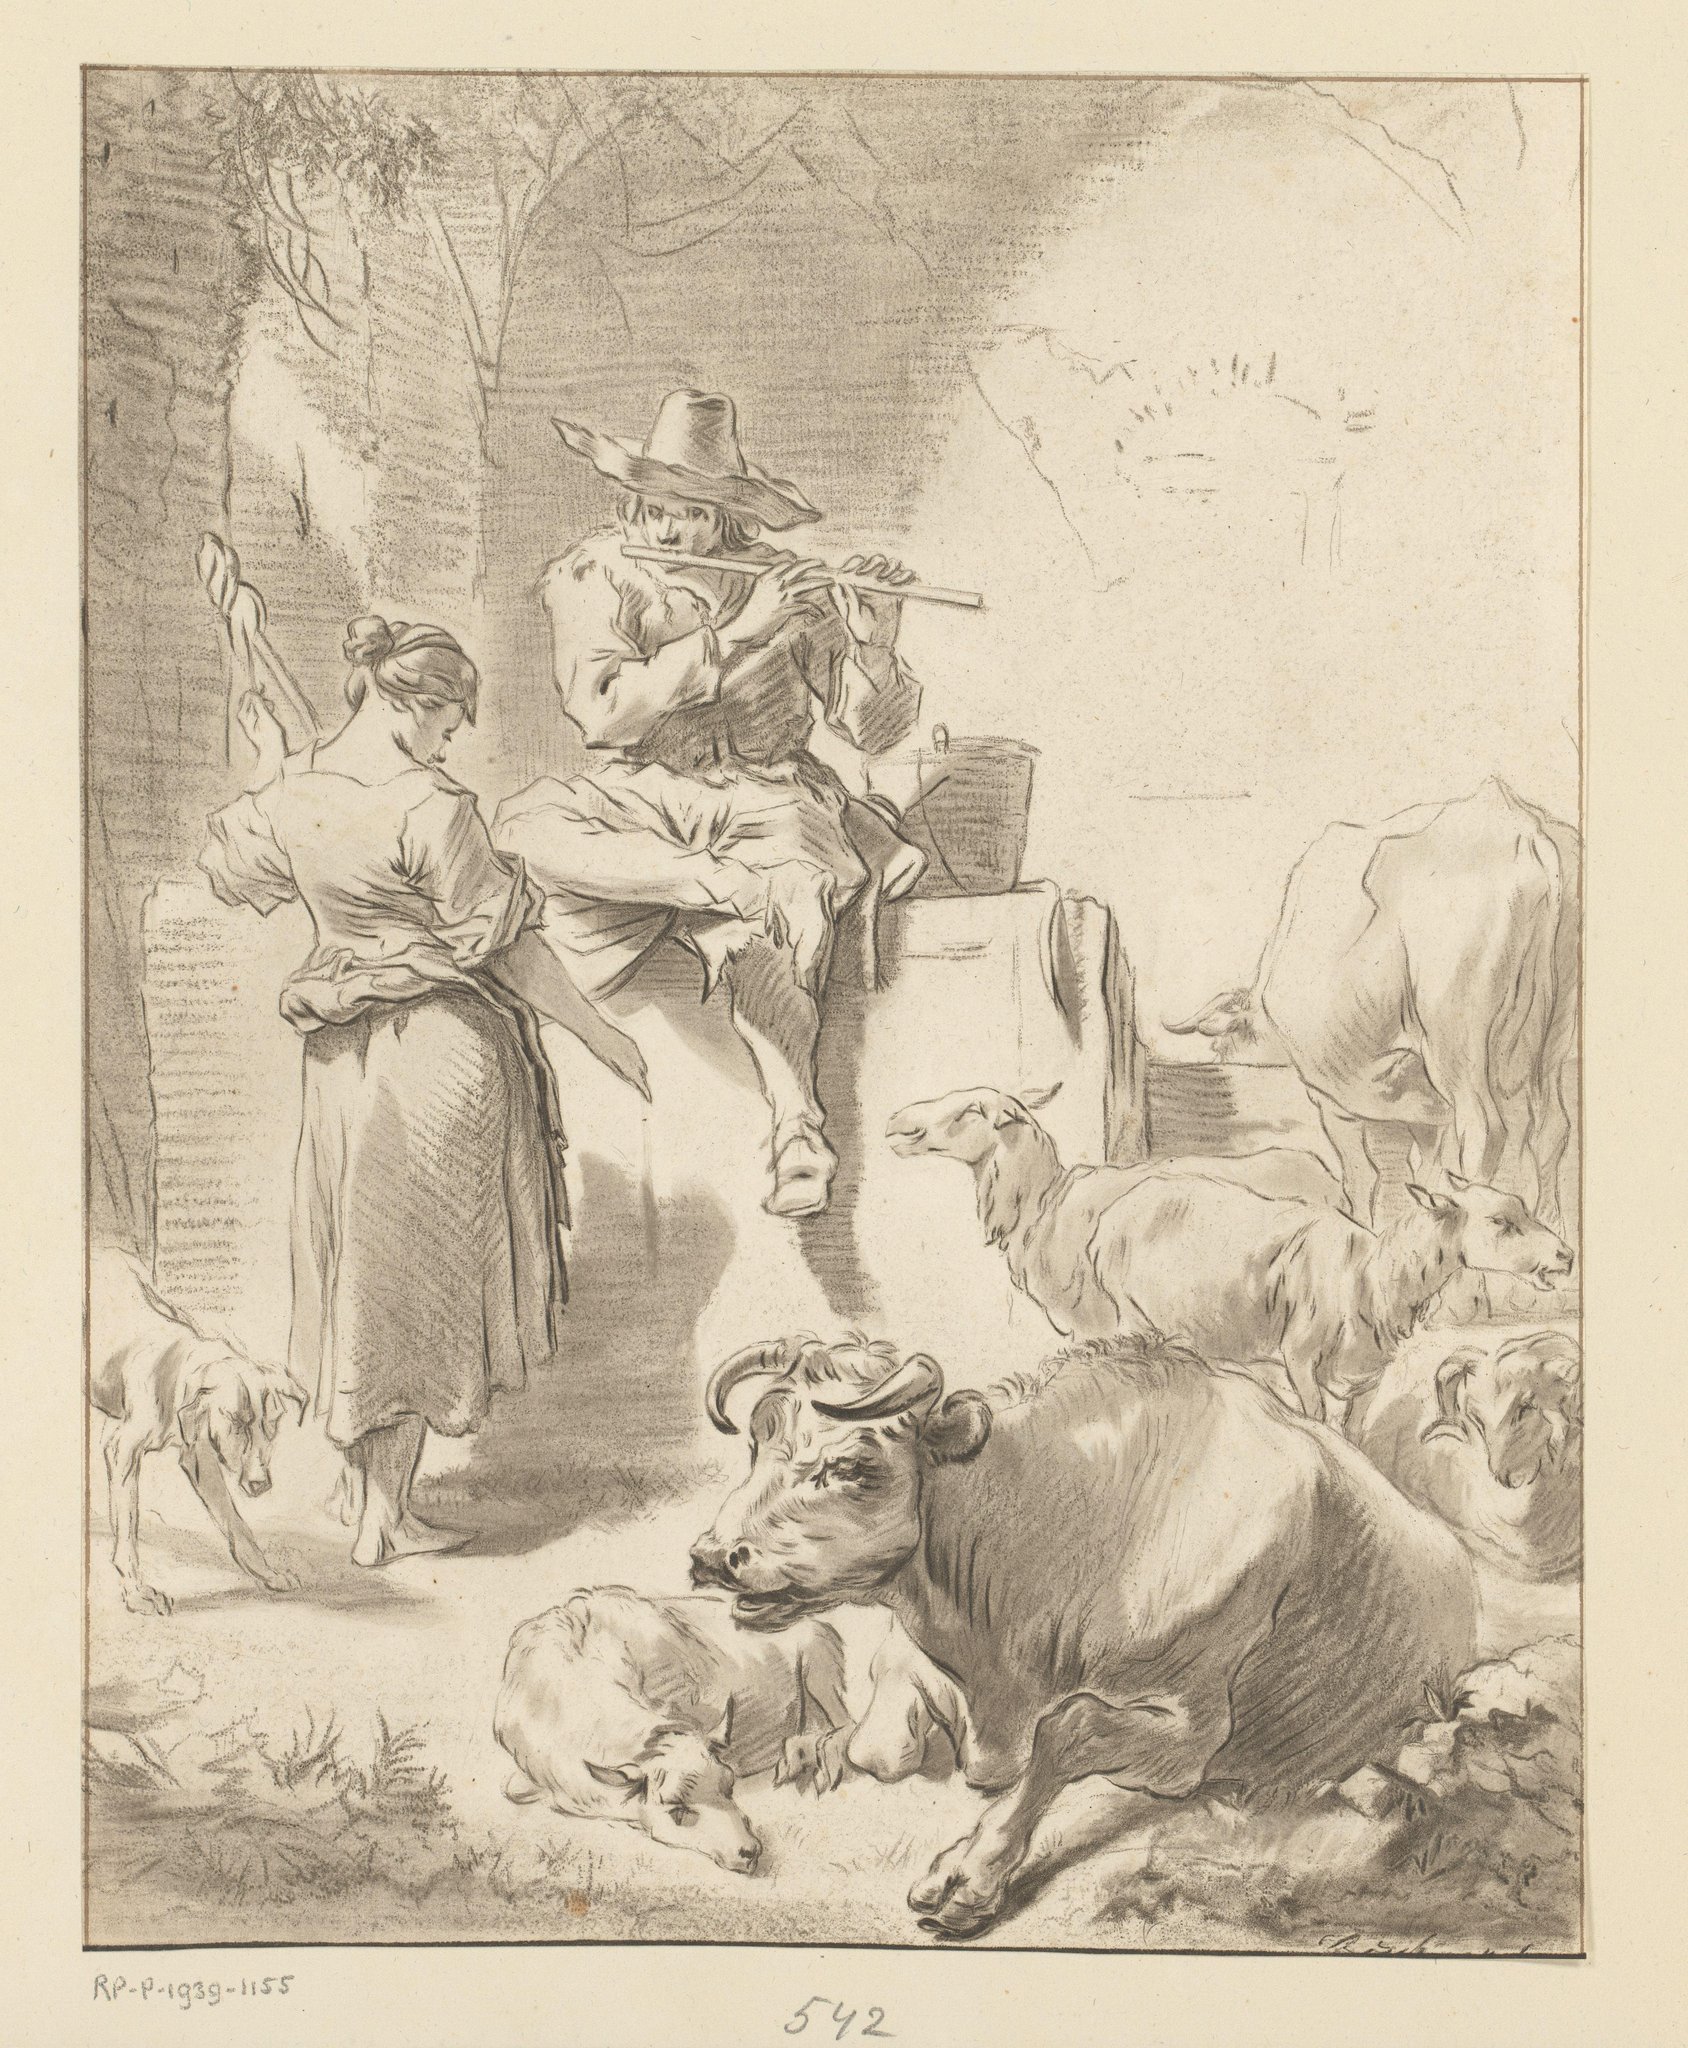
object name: print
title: Fluitspelende herder en spinnende herderin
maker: jurriaan cootwijck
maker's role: print maker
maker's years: 1714-1798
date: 1724-1798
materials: paper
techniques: printmaking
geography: amsterdam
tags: one person playing wind instrument - cc - out of doors, herding, herdsman, herdswoman, shepherd, shepherdess, cowherd, etc., spinning (manufacture of yarn), herd, flock, flute, aulos, tibia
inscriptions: inscription: ‘J Cootwijk/ Fecit’, collector's mark: ‘RIJKS / MUSM’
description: Een herder zit op een rots en speelt fluit. Naast hem staat een herderin die spint. Geiten en koeien liggen rondom het paar. Onder de prent een potloodtekening van een man met een hoed. De prent ligt los in een album, zie blad 139.